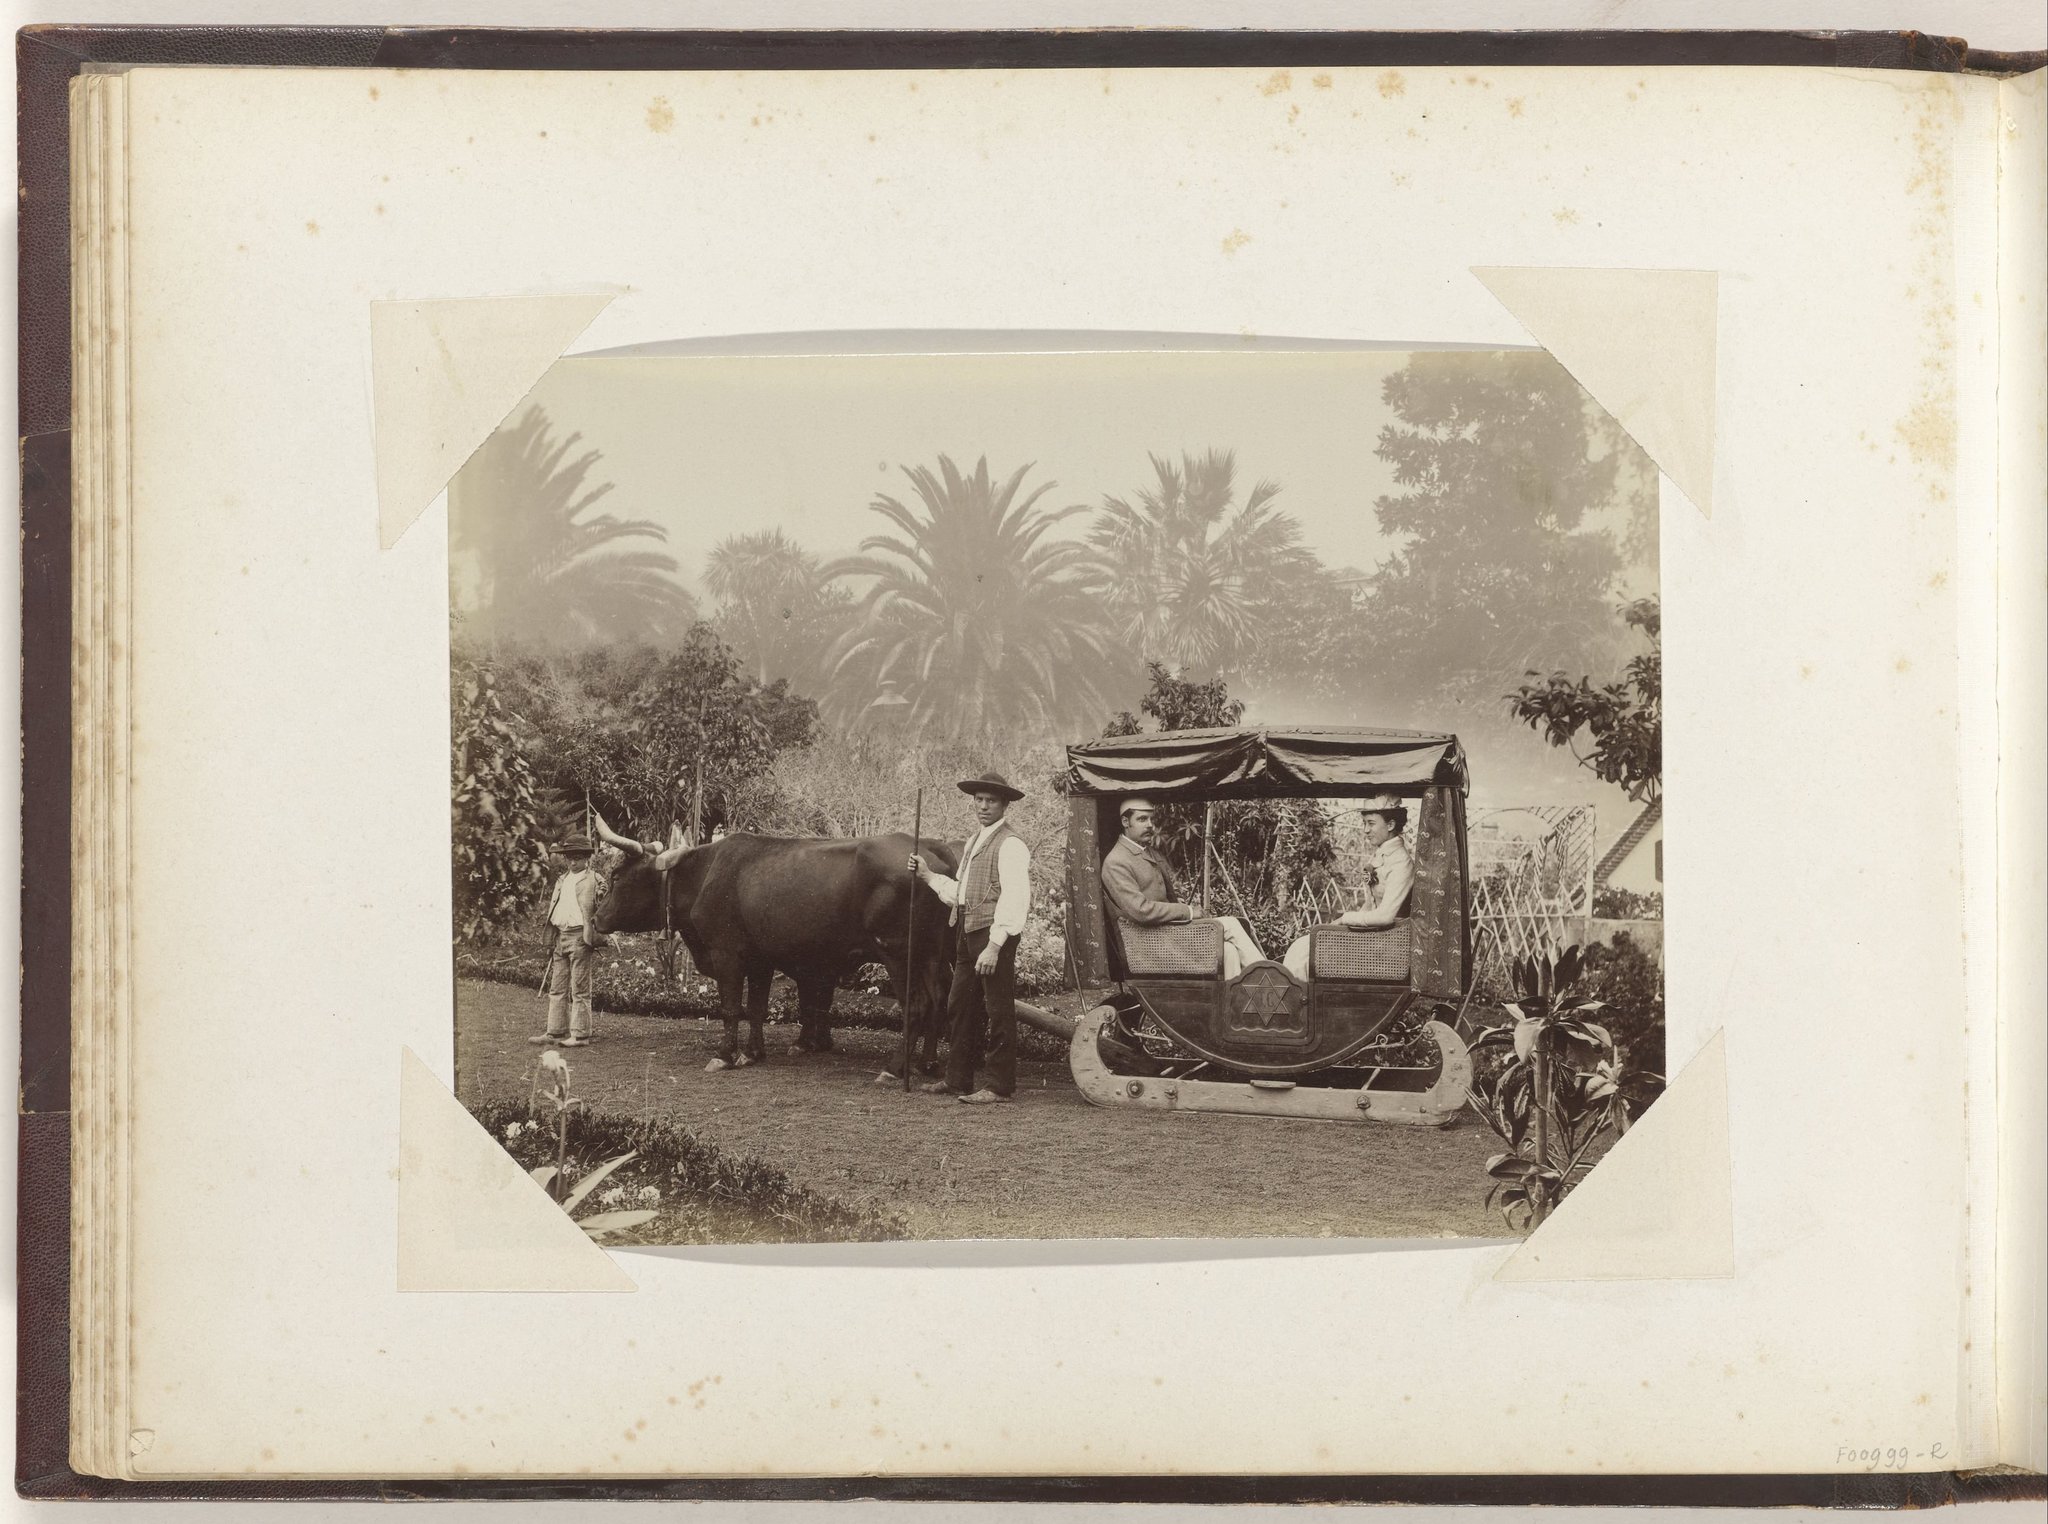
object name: photograph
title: Europees paar in een door een stier getrokken draagkar met glij-ijzers (toeslede) op Madeira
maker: Anonymous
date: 1885-1910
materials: paper, photographic support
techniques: albumen print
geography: madeira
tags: sleigh, sledge (non-sport), animal-drawn sledge (dutch: 'toeslede')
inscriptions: inscription: ‘[...]Car Madeira’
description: Onderdeel van Album met 191 foto's van een reis naar en door Zuid-Afrika.